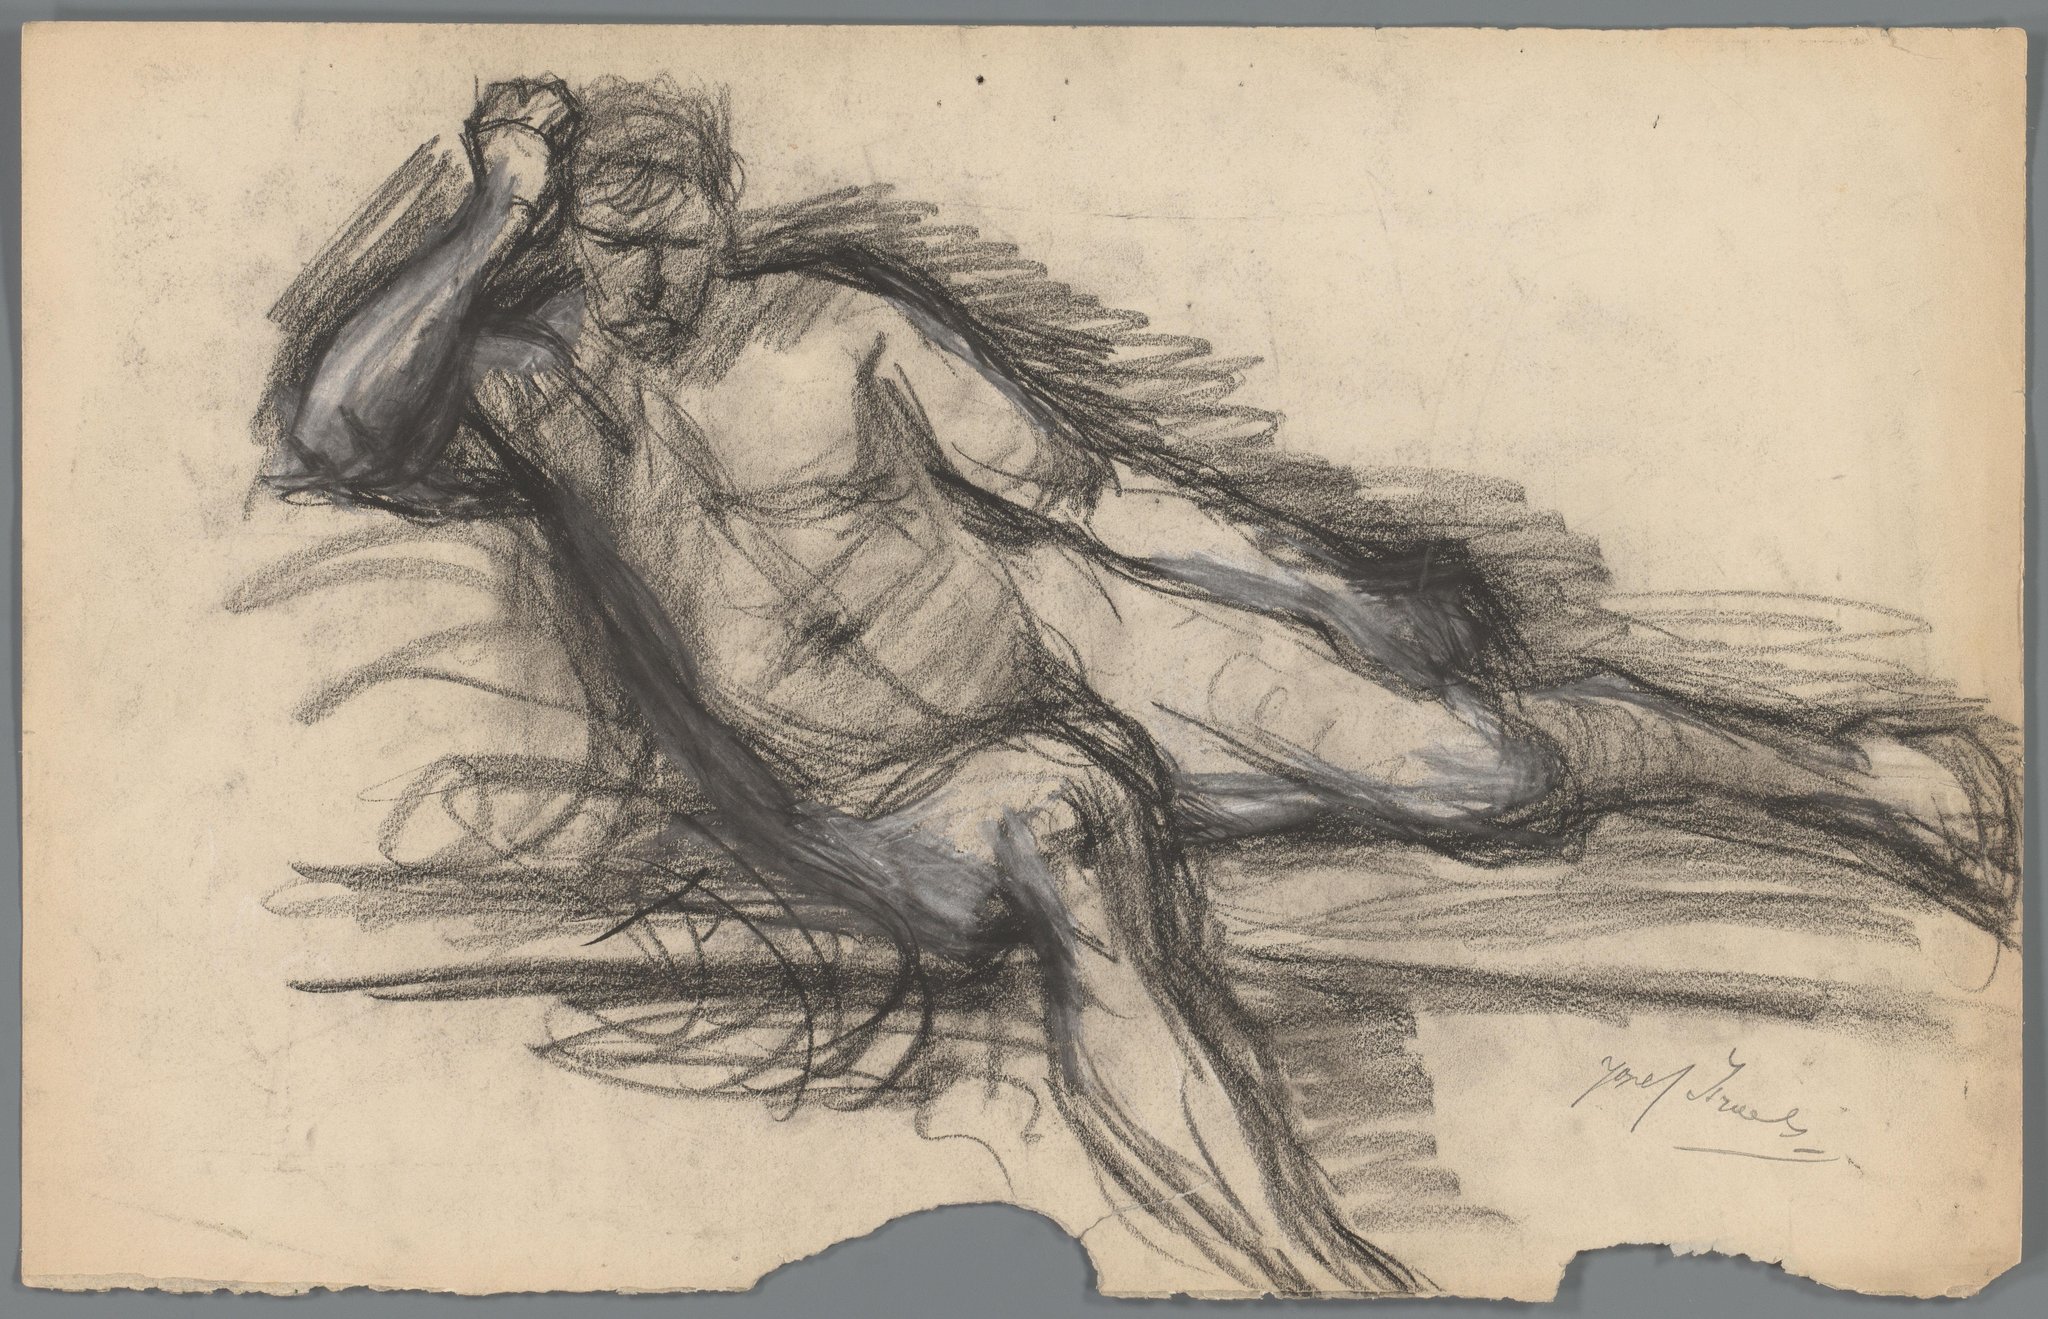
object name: drawing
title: Liggende Saul, het hoofd ondersteunend met de rechterhand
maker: jozef israëls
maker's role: draughtsman, painter, print maker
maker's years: 1824-1911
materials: chalk, paper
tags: story of saul, lying figure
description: Voorstudie voor het schilderij 'David en Saul' dat zich in het Groninger Museum bevindt.